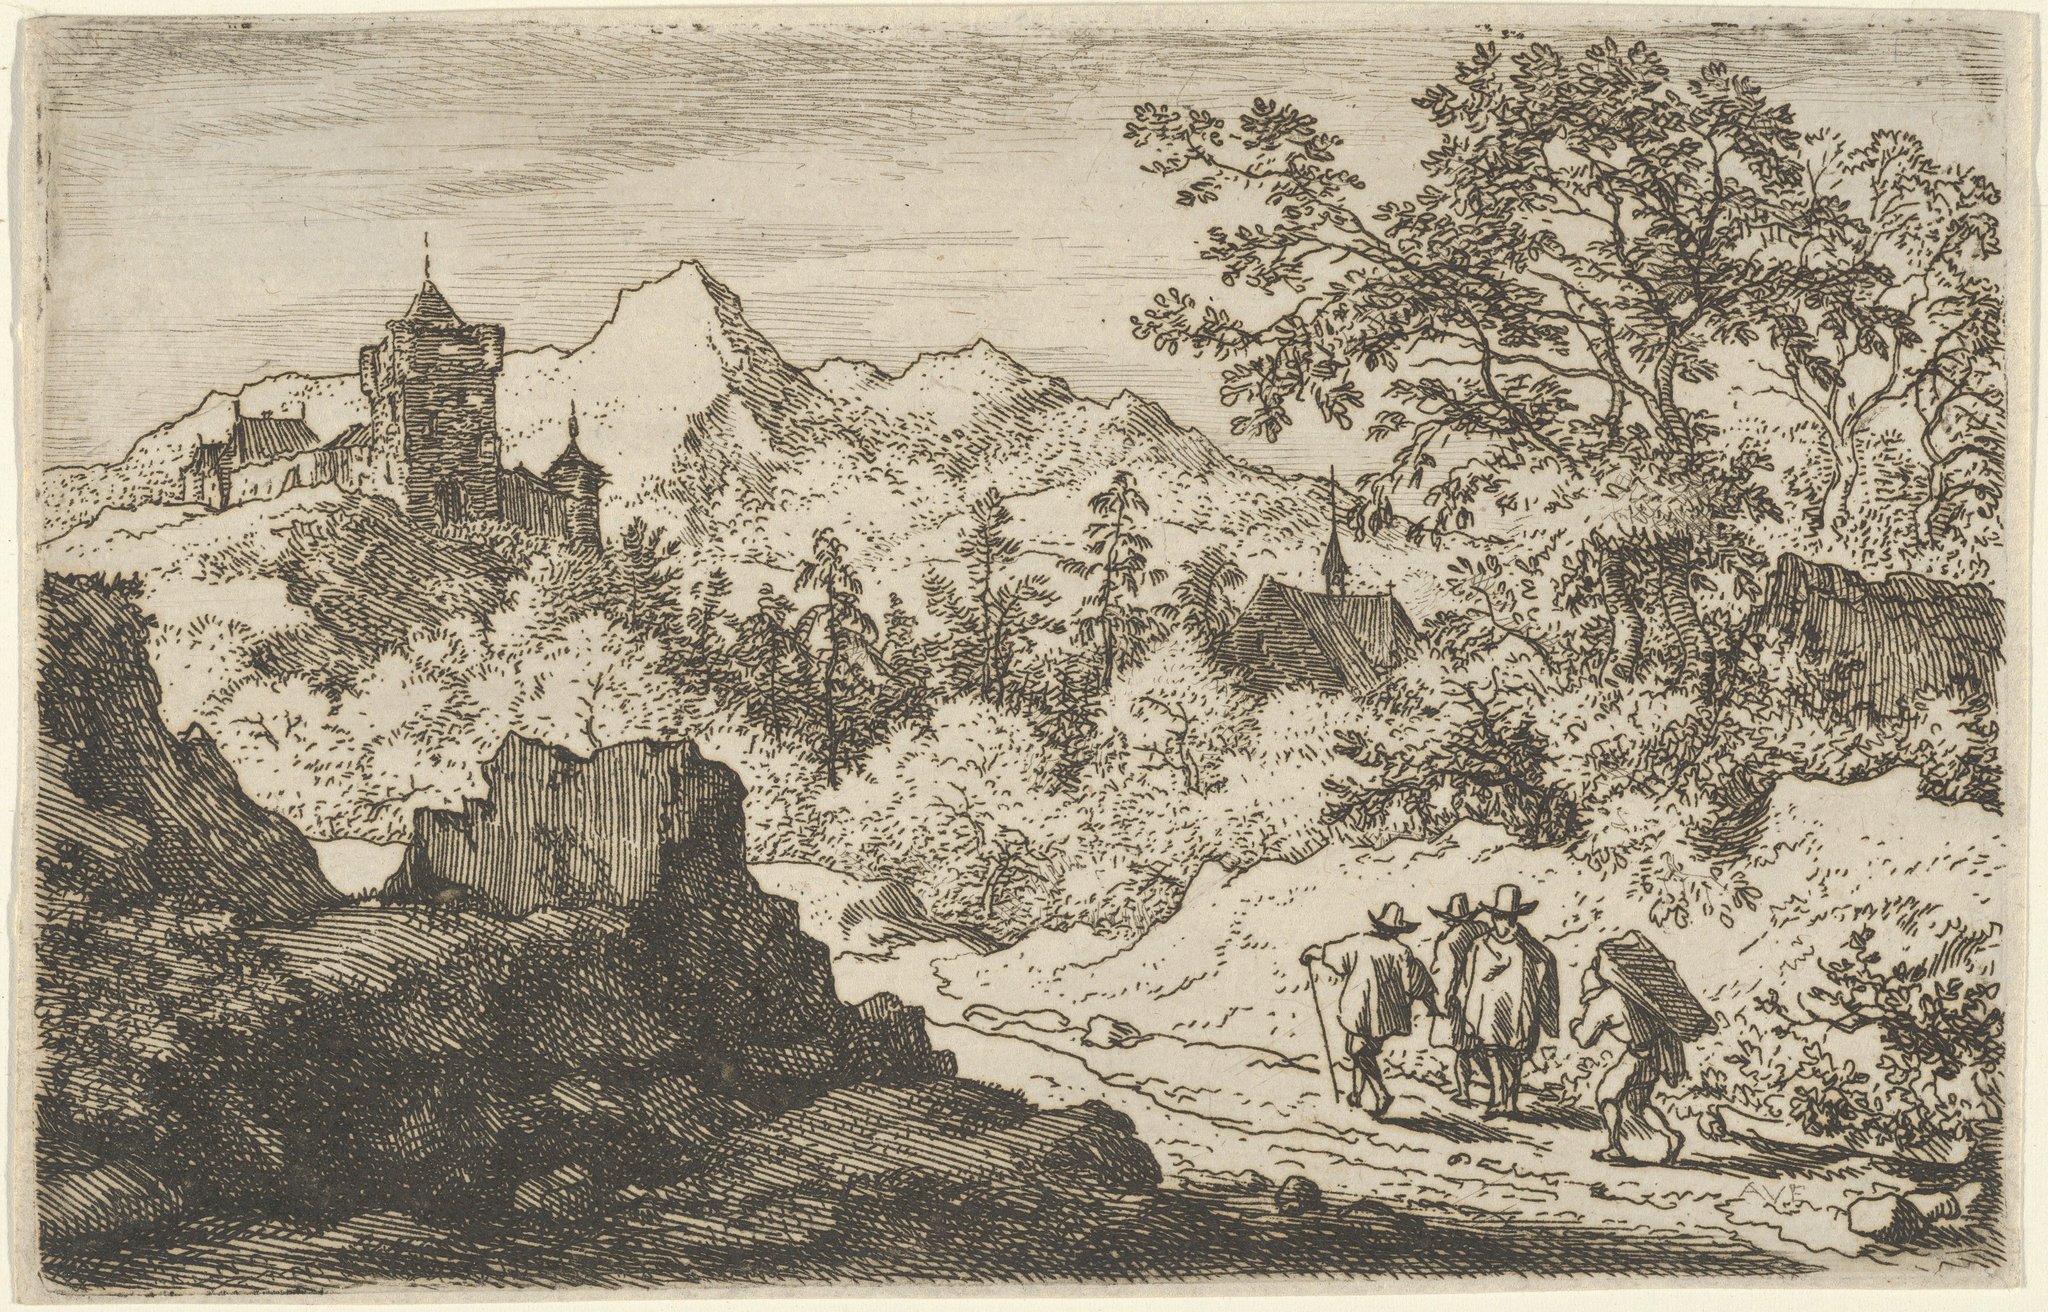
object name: print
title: The Three Men and the Porter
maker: allart van everdingen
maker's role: artist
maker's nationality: dutch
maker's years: 1621-1675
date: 1621-1675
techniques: engraving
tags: buildings,roads,men